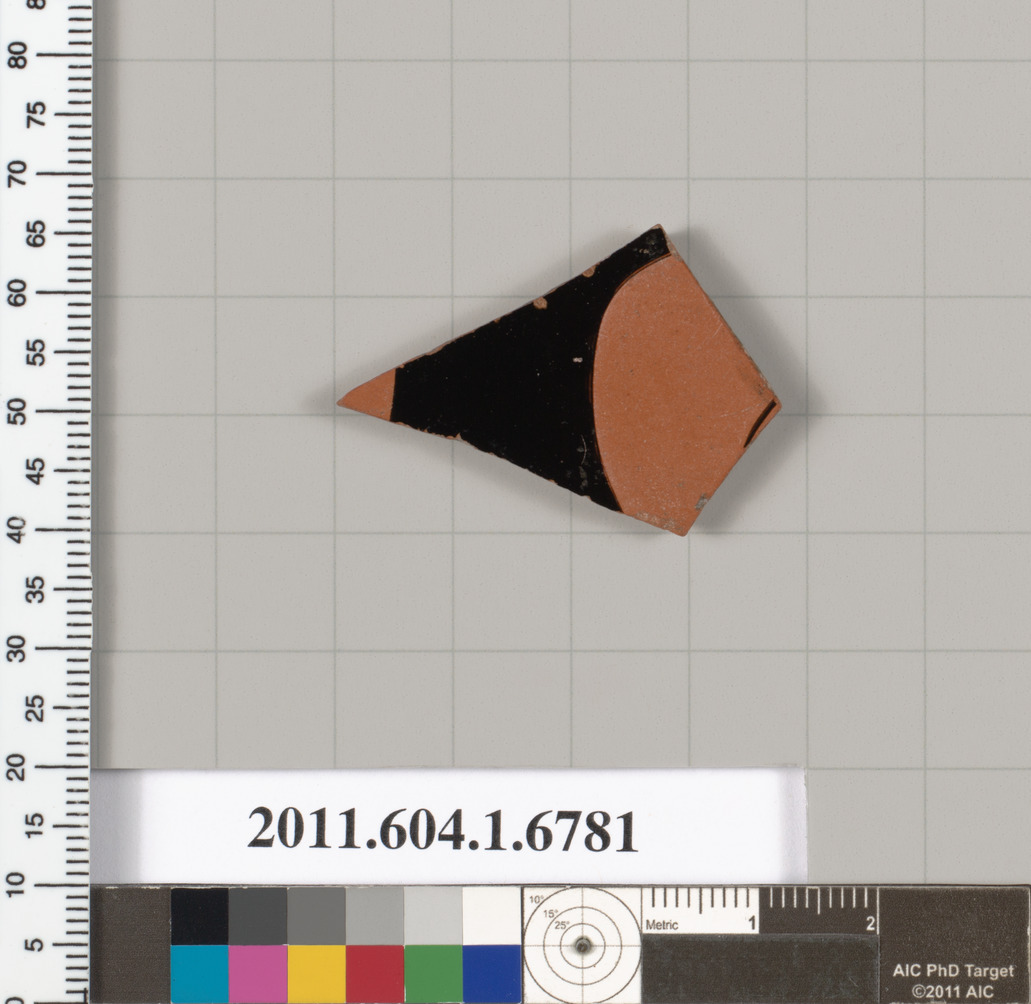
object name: kylix fragment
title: Terracotta fragment of a kylix (drinking cup)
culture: greek, attic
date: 490-470 BCE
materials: terracotta